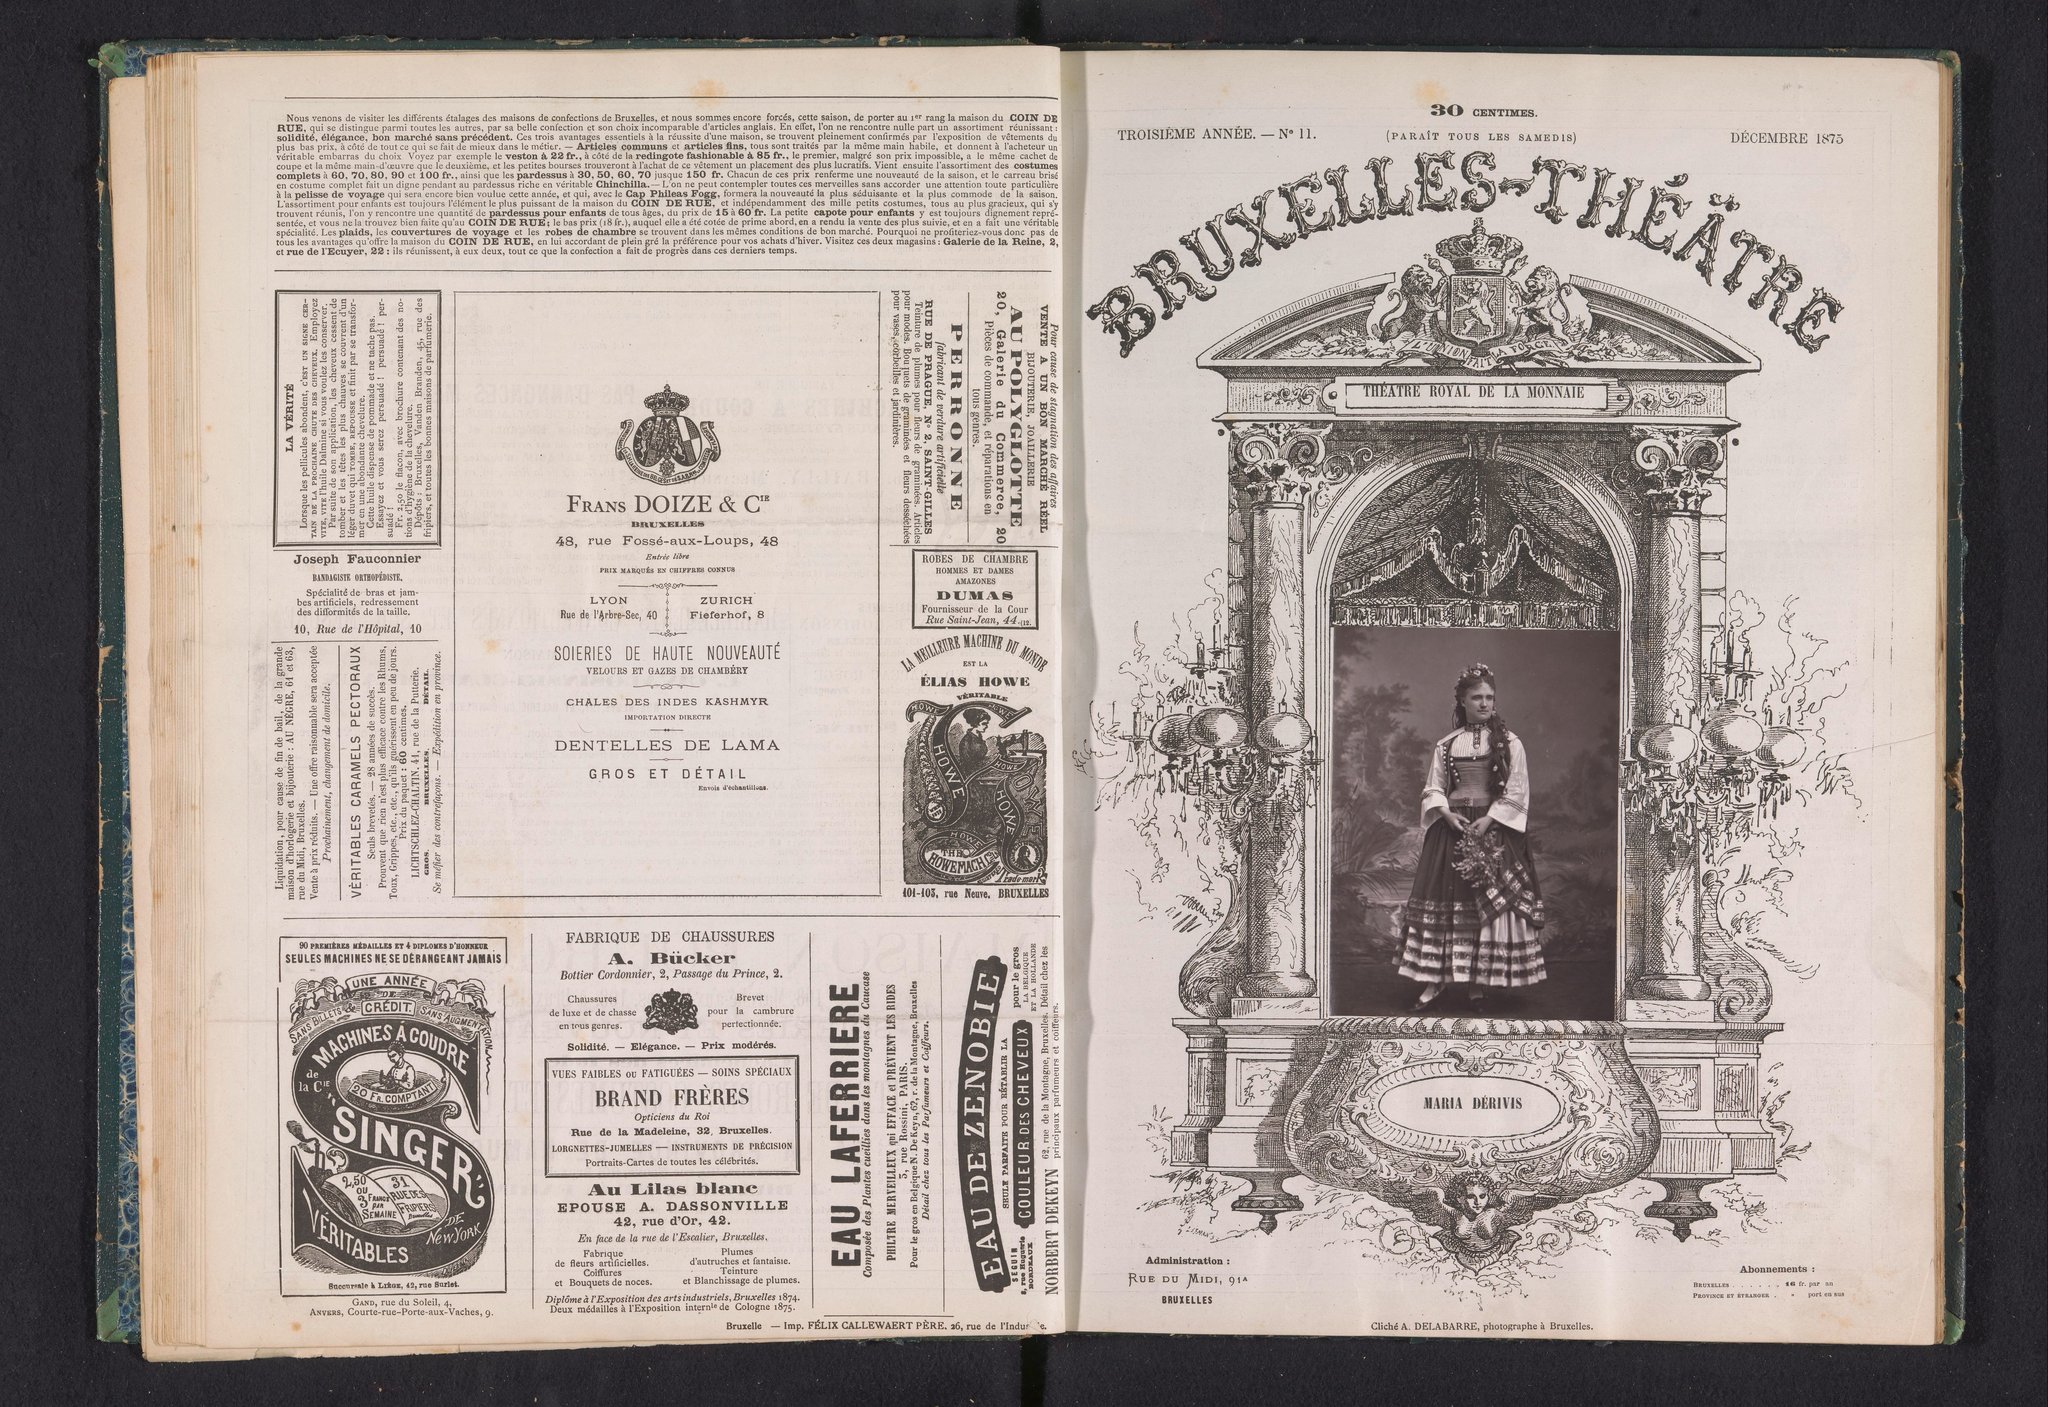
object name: page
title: Portret van Maria Dérivis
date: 1870-1875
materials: paper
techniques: woodburytype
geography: brussels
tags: portrait of actor, actress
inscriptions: number: ‘No 11.’